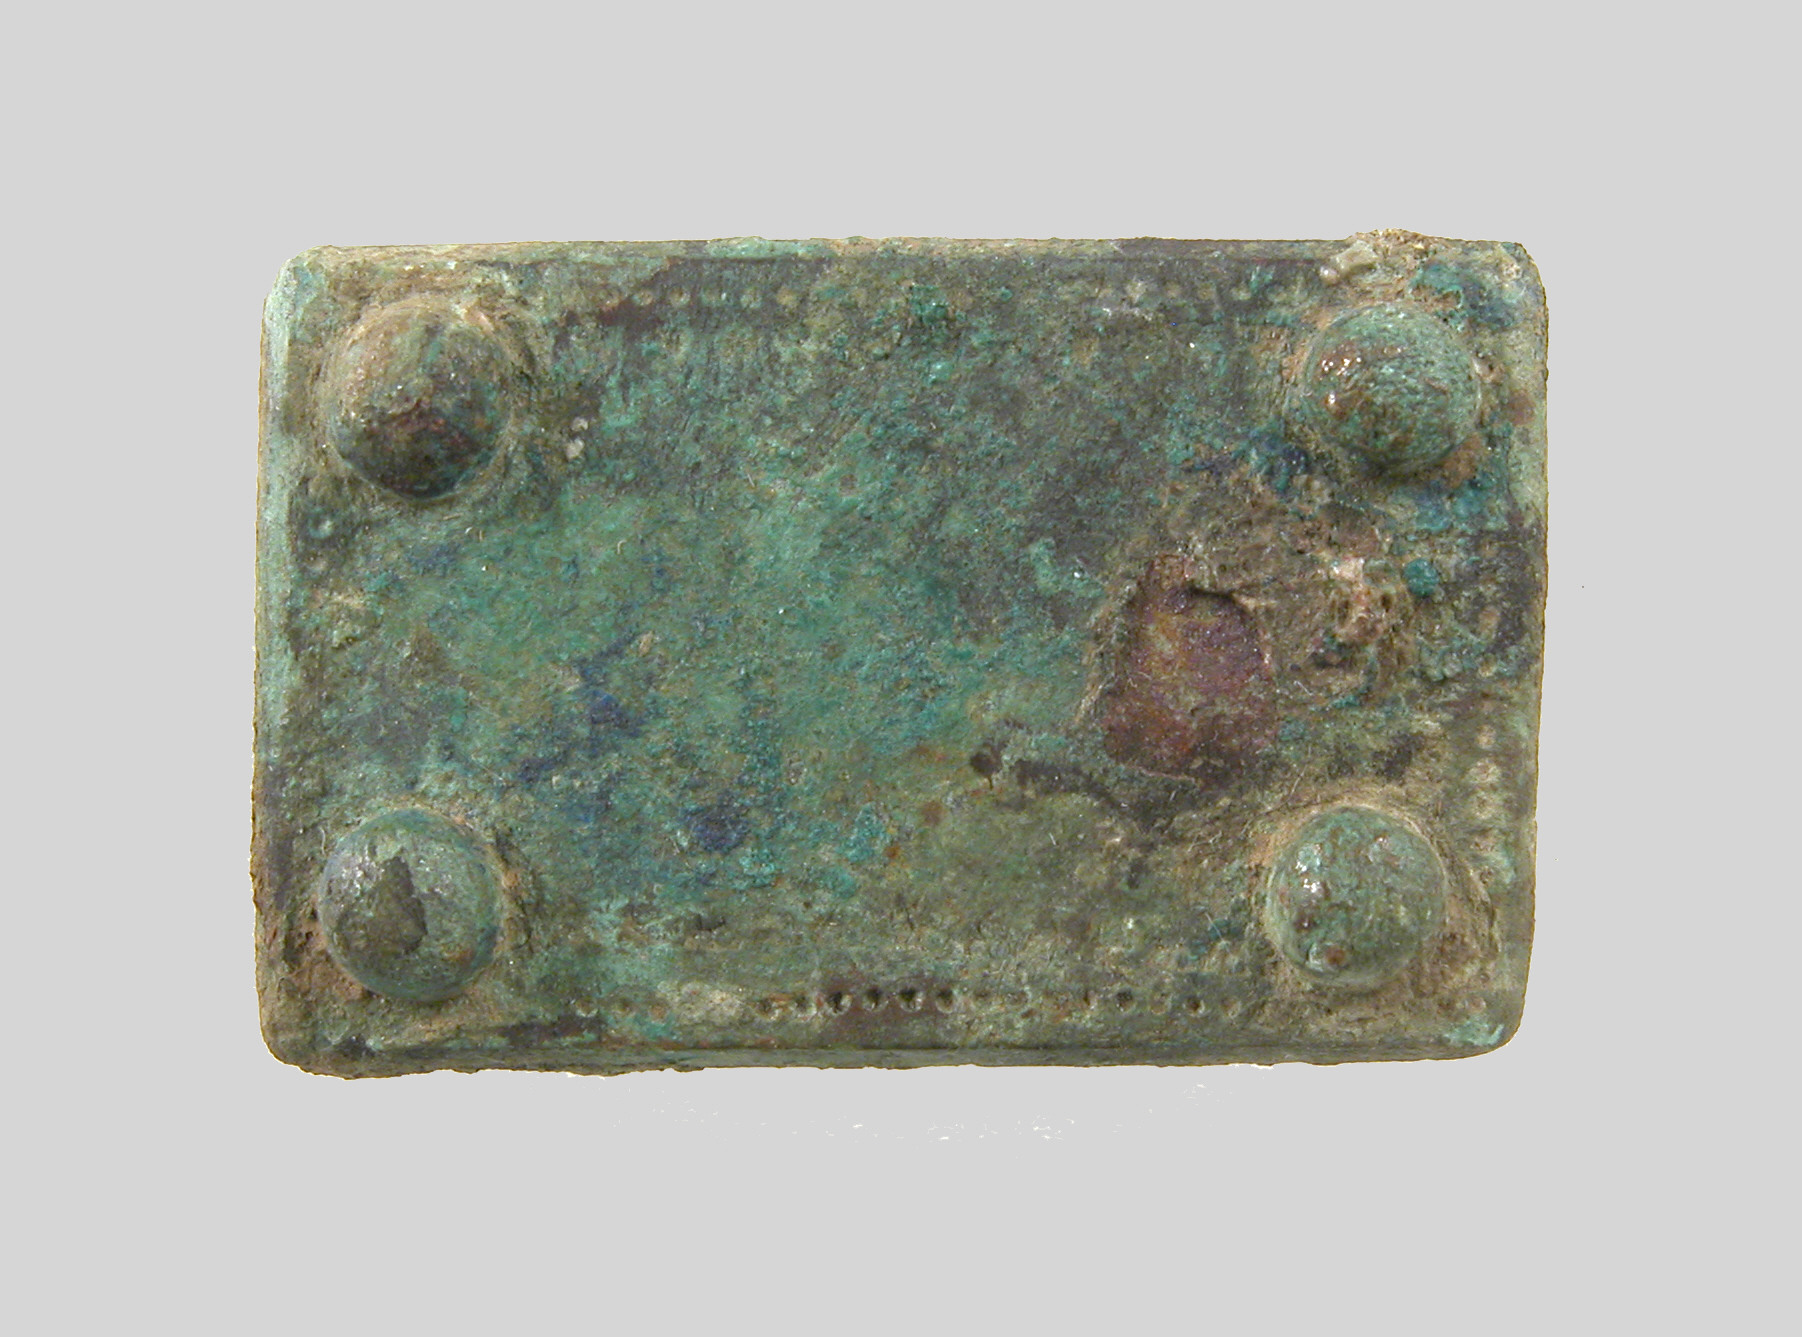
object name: plaque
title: Rectangular Plaque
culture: frankish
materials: copper alloy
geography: germany